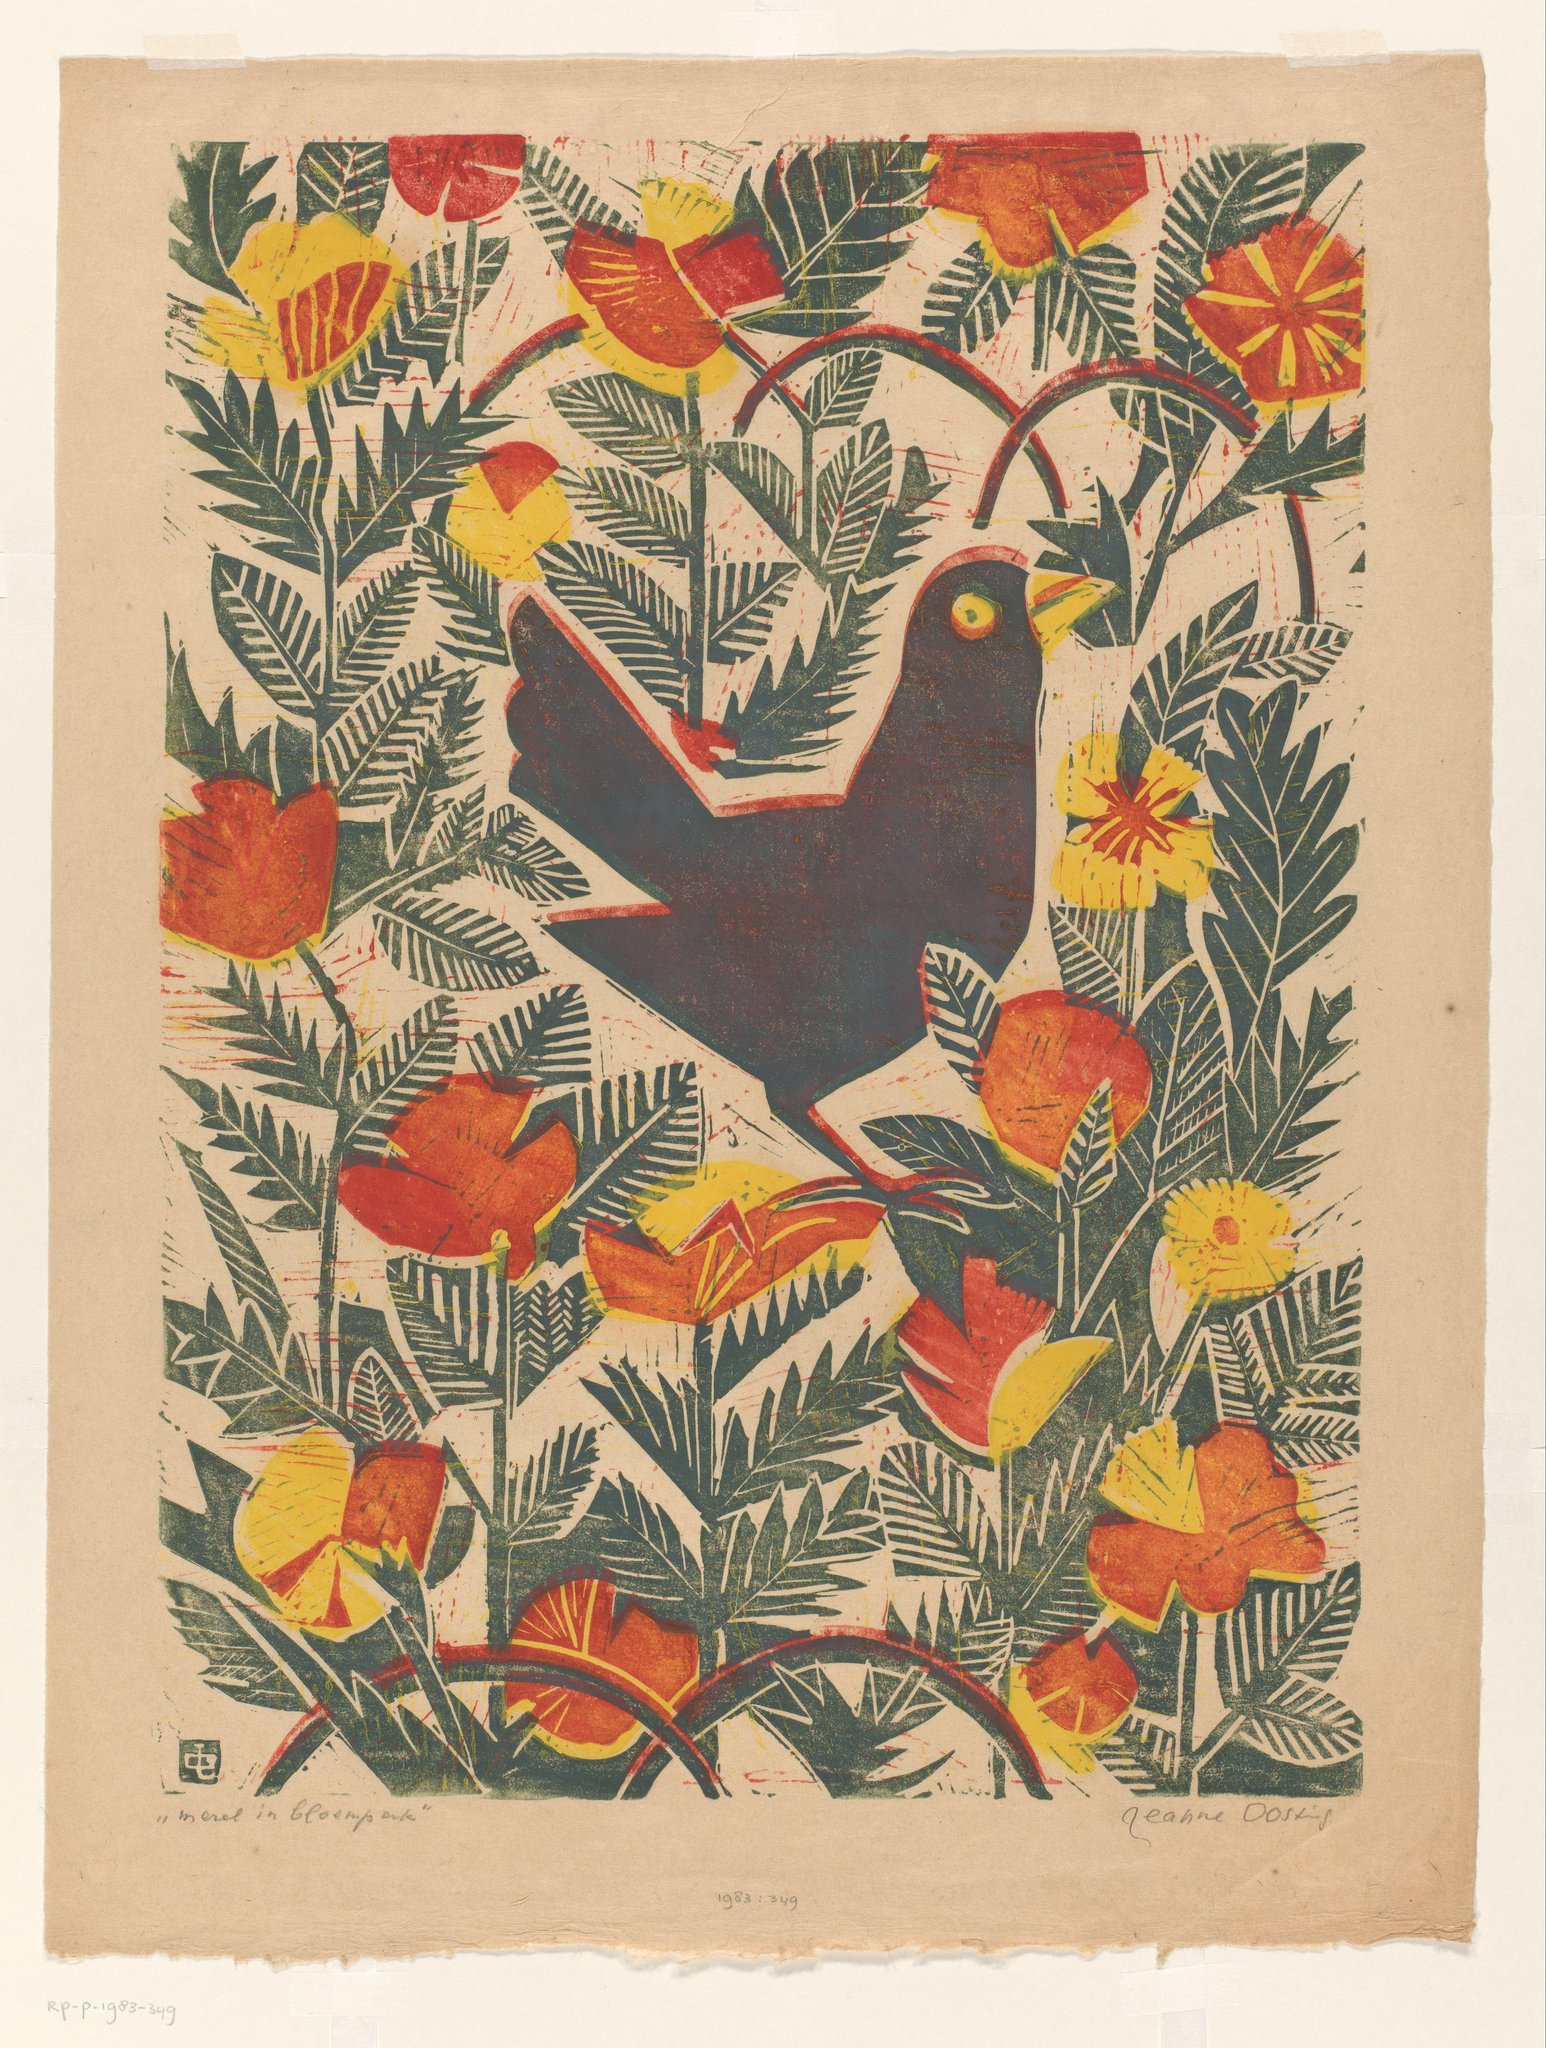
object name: print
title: Kluizenaar en vrouwen aan tafel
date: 1834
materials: paper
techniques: aquatint, engraving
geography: amsterdam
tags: sitting figure - aa - female human figure, anchorite, hermit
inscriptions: collector's mark: Lugt 2760, collector's mark: Lugt 2228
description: Een oude kluizenaar zit met drie jonge vrouwen aan een tafel. De vrouwen plagen de oude man. Ze geven hem een krans van herfstbloemen, ze nemen hem de bijbel uit de hand, binden een paraplu aan zijn handen en trekken hem aan zijn baard.